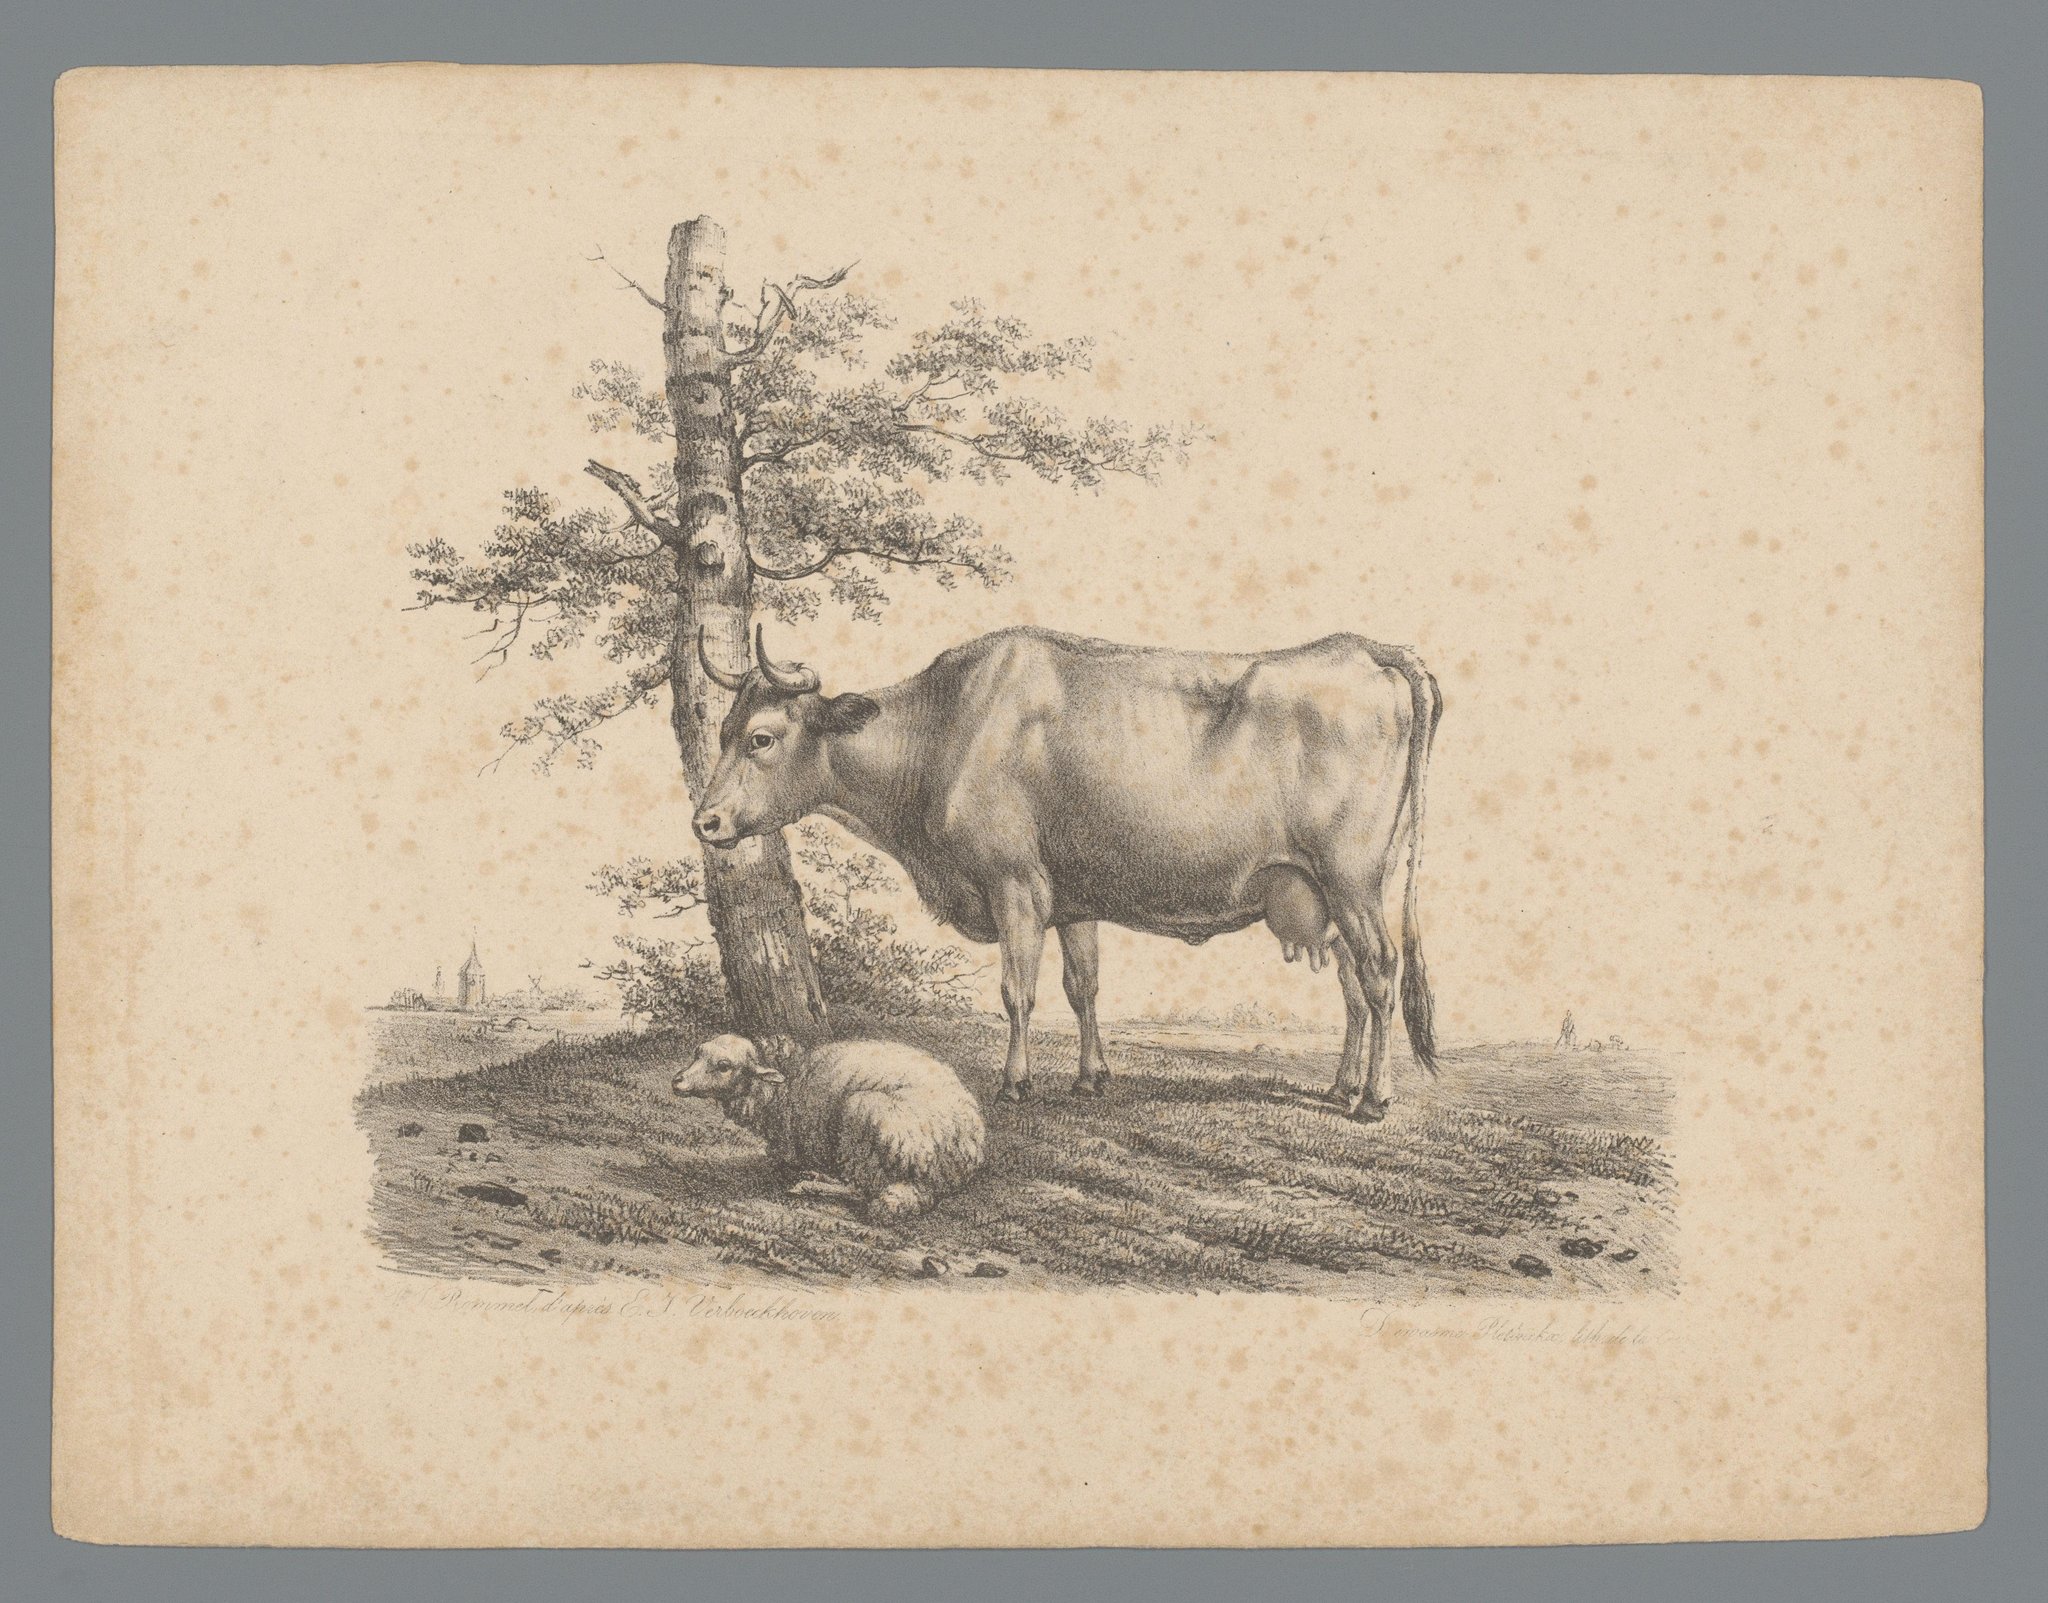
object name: print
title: Schaap en koe bij een boom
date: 1824-1827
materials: paper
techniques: lithograph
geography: brussels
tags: cow, sheep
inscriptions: collector's mark: Lugt 2228